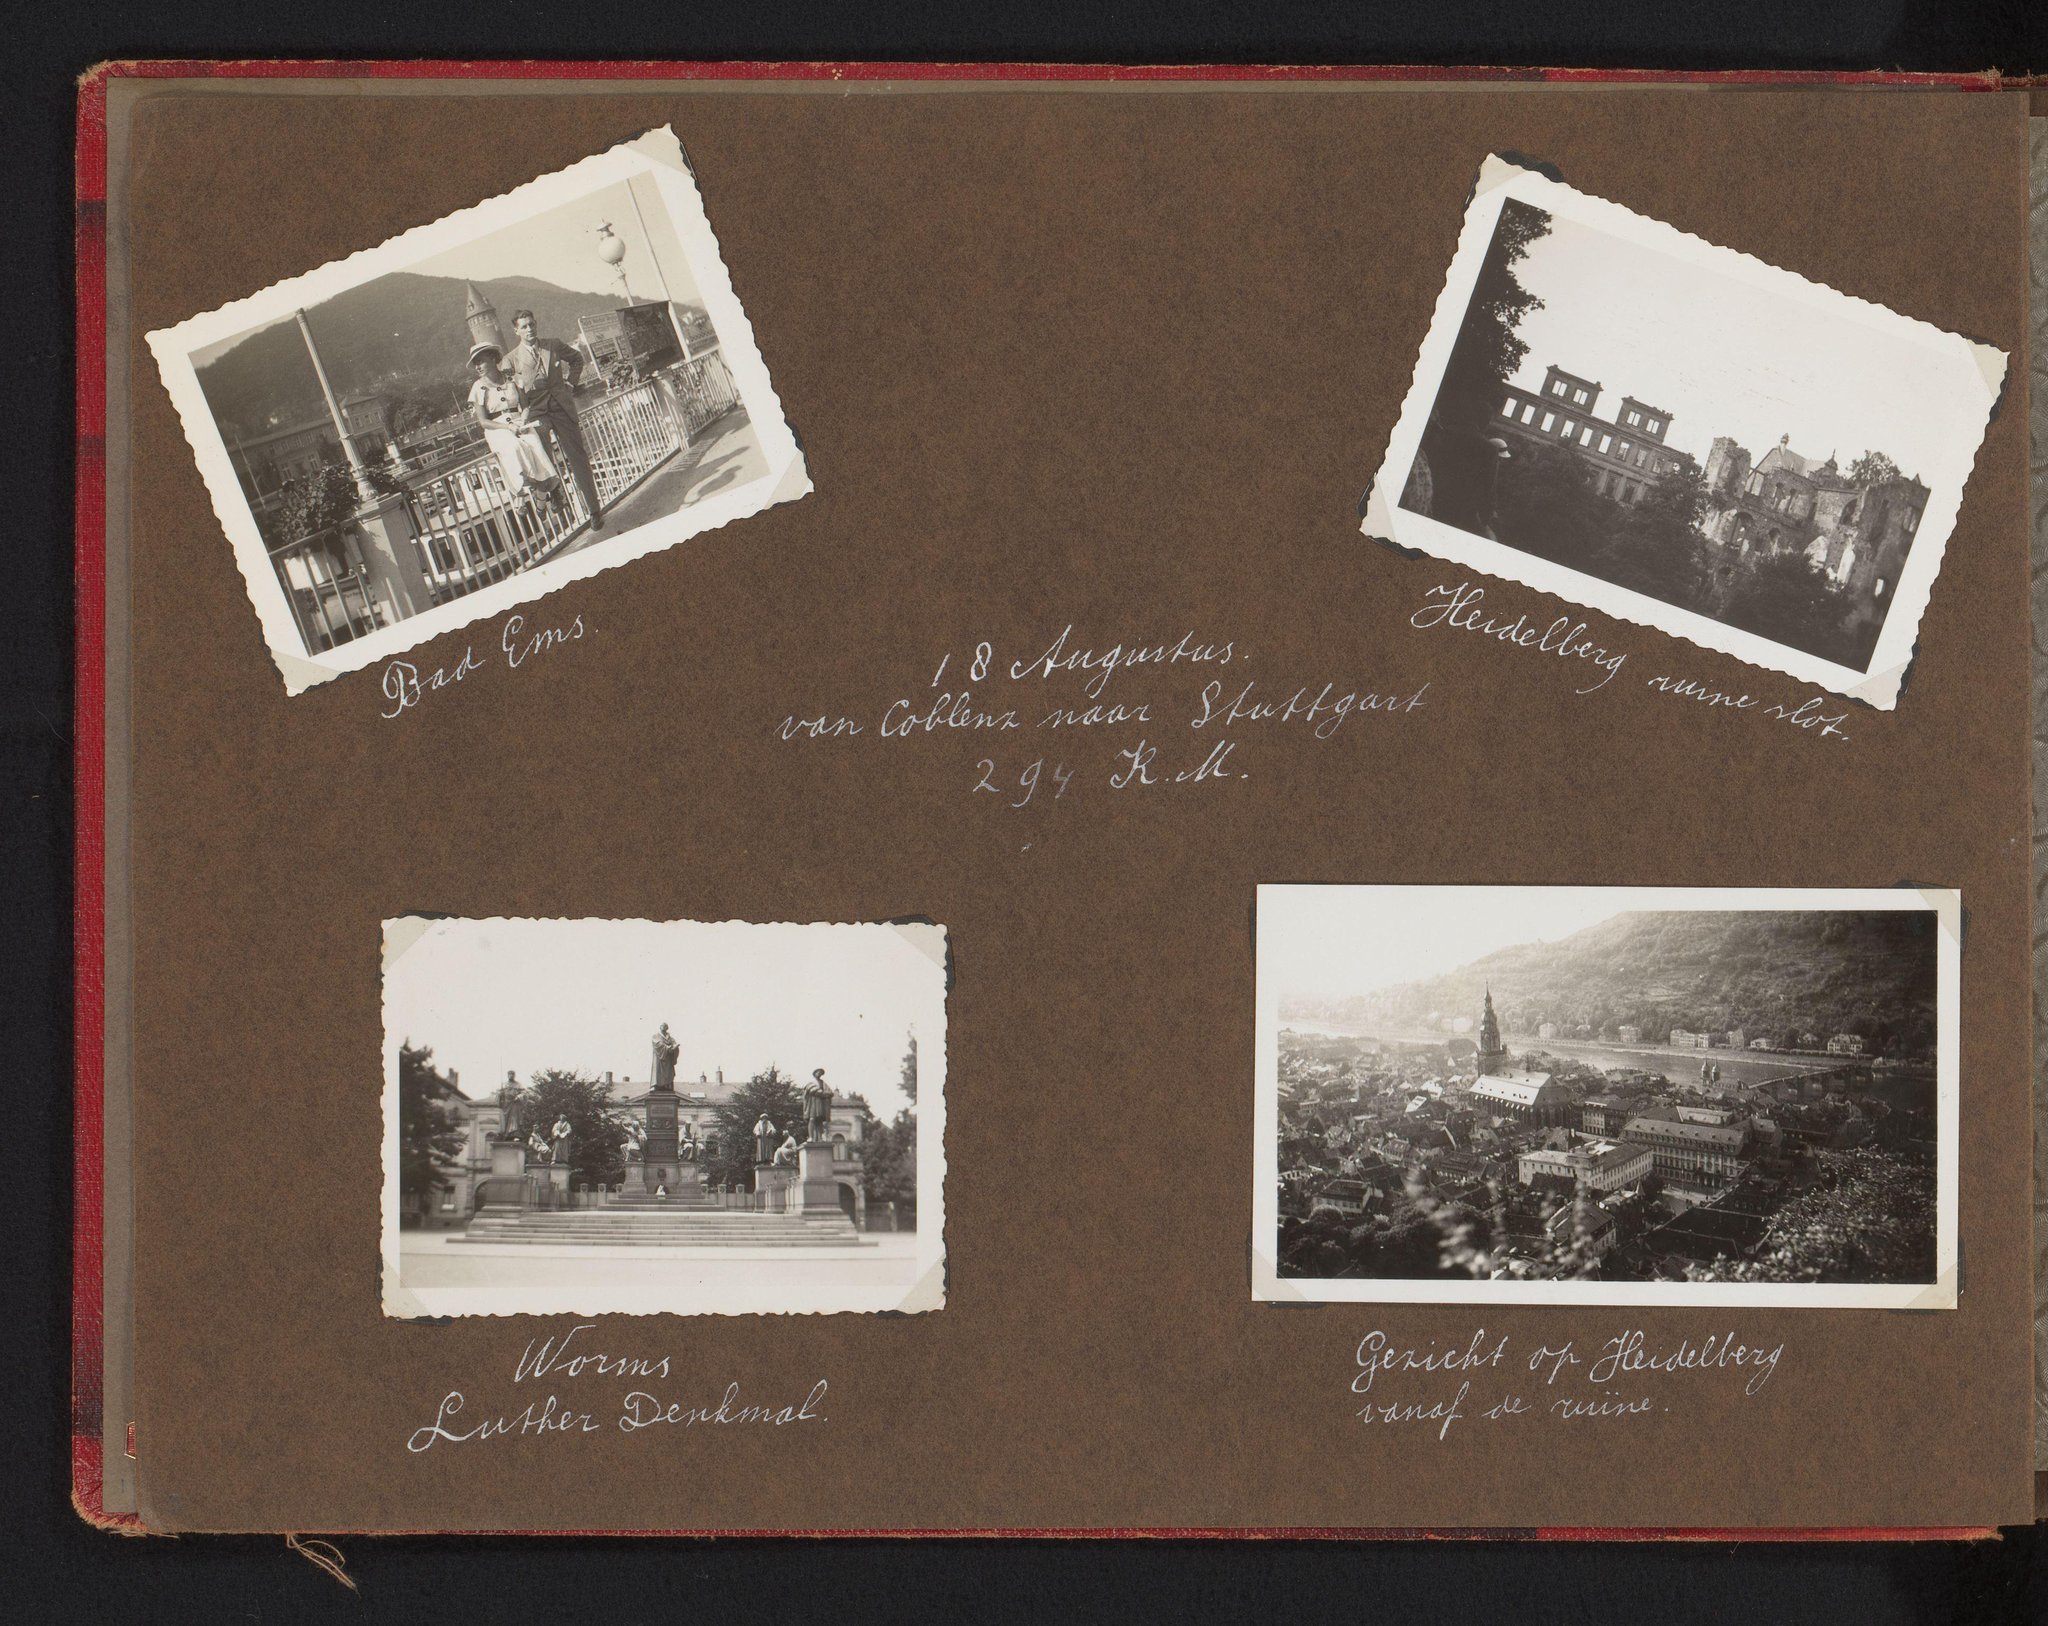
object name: photograph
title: 18 Augustus. van Coblenz naar Stuttgart 294 K.M.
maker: Anonymous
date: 1908-1935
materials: paper, photographic support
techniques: gelatin silver print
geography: germany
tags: city-view in general; 'veduta', outing, pleasure trip, germany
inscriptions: inscription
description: Albumblad met vier foto's van gezichten te Heidelberg en Worms, augustus 1935. Onderdeel van het reisalbum van de familie Van den Broek 1935-1937.